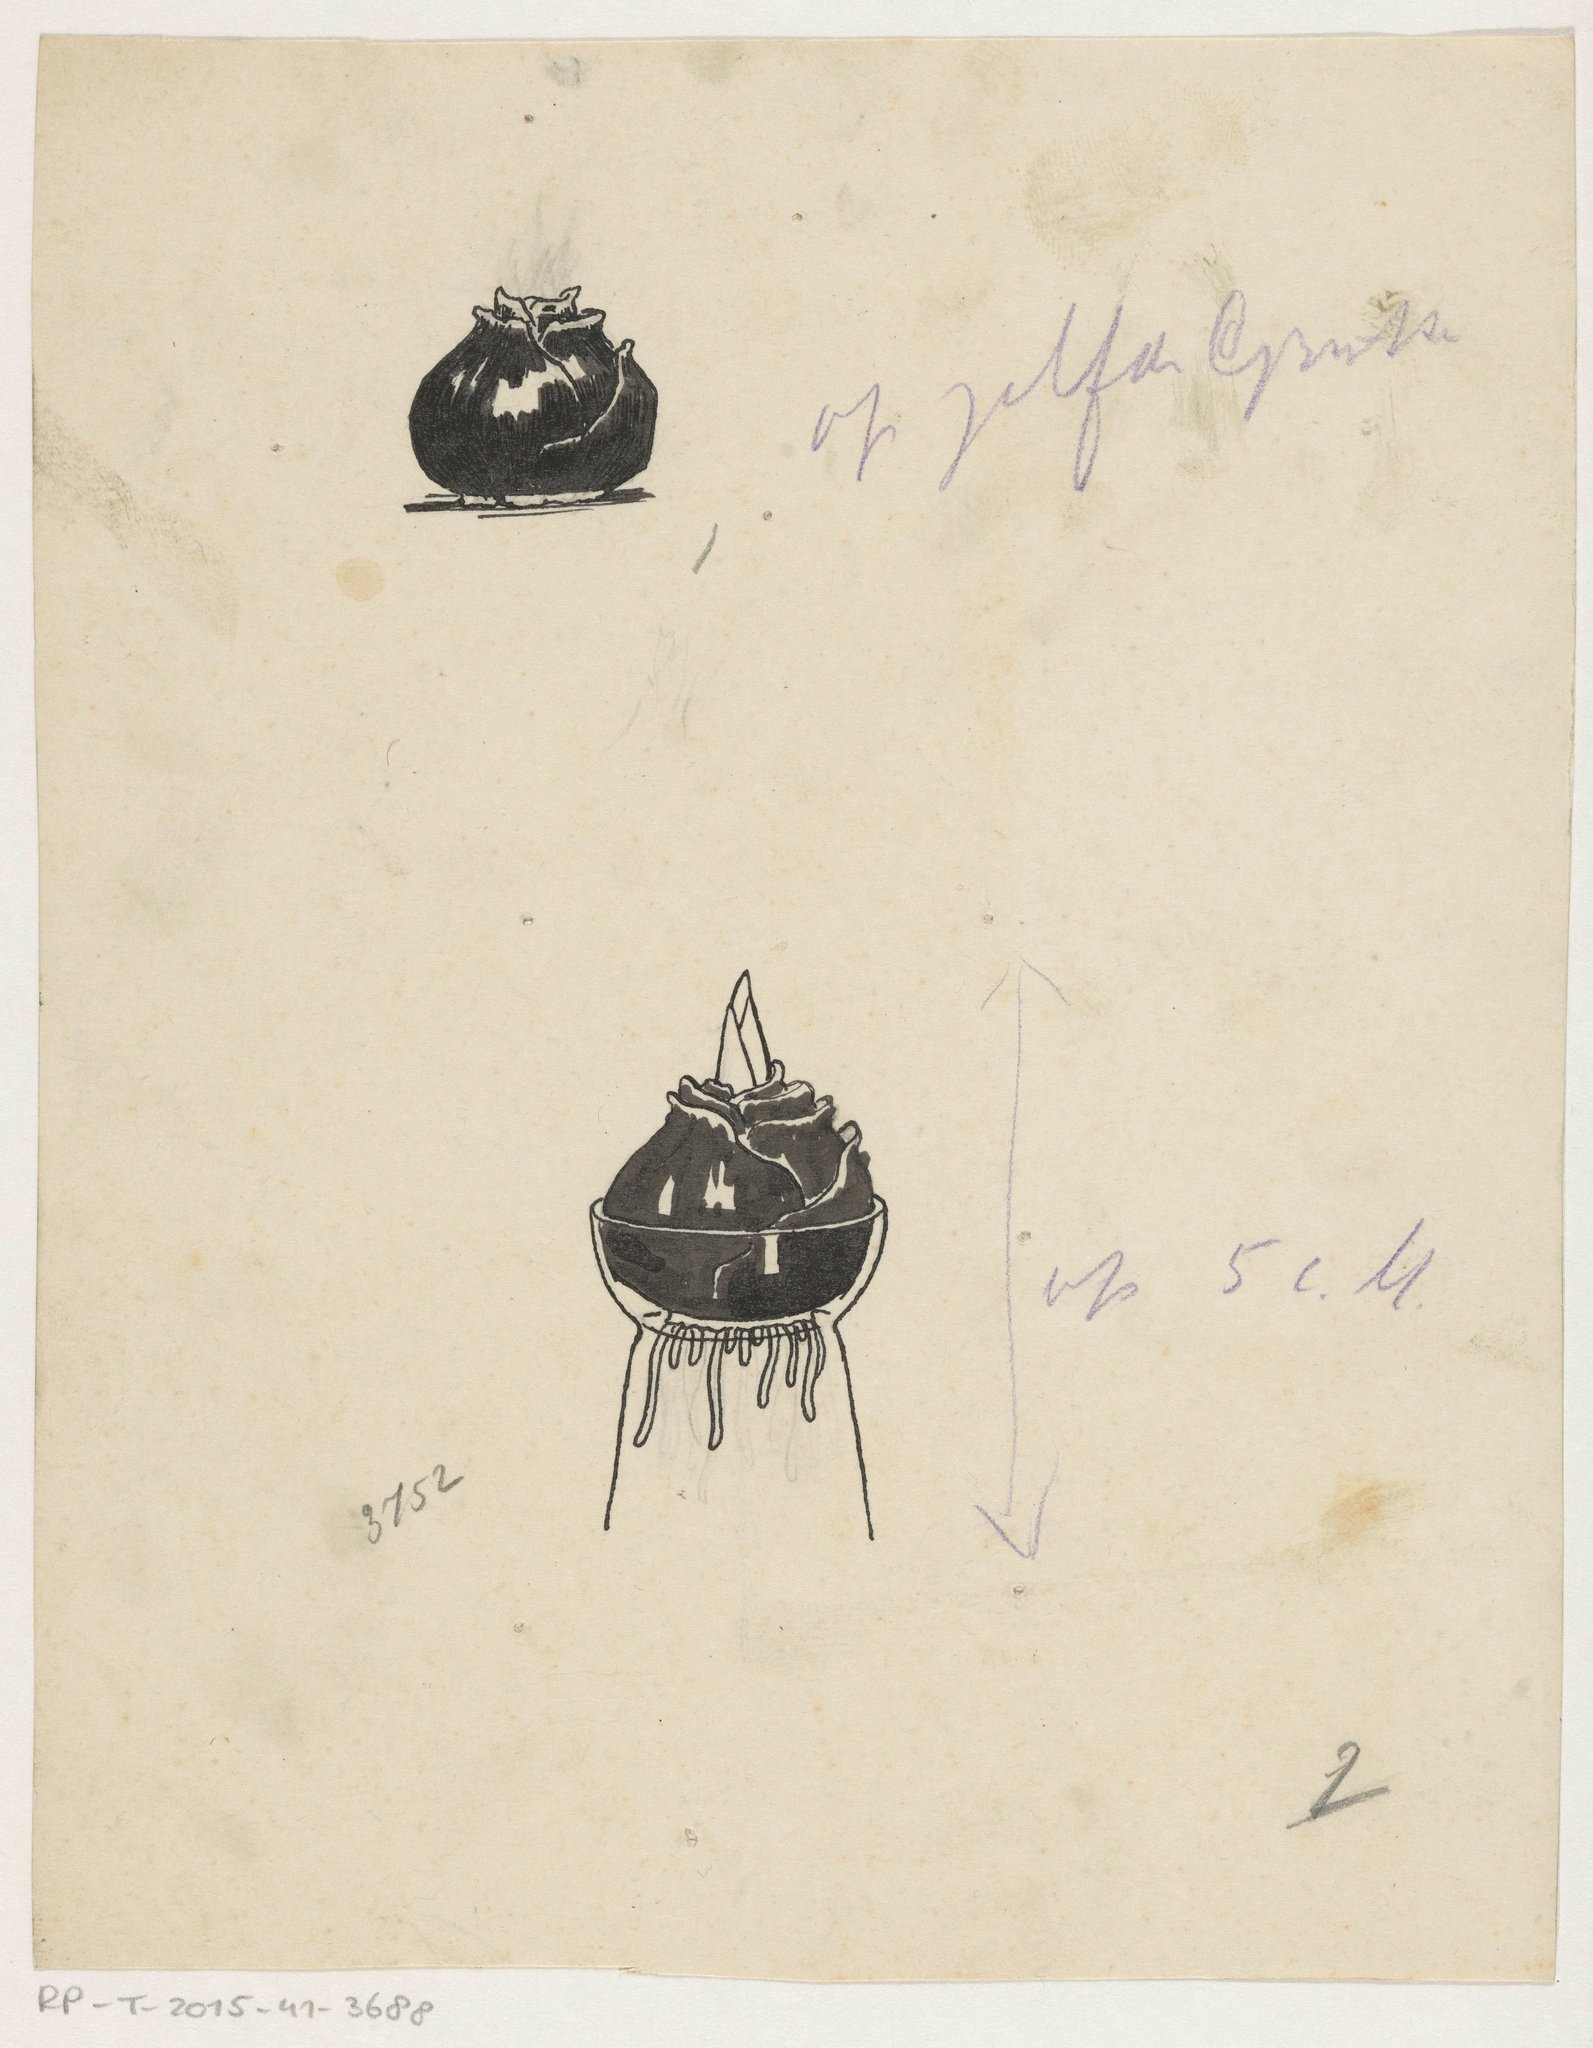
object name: drawing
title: Twee bloembollen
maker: Anonymous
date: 1880-1930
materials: ink, paper, pencil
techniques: brush, pen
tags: flowers: hyacinth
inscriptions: :, collector's mark: Lugt 2228a, number: ‘2’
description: Twee bloembollen, vermoedelijk van een hyacint.